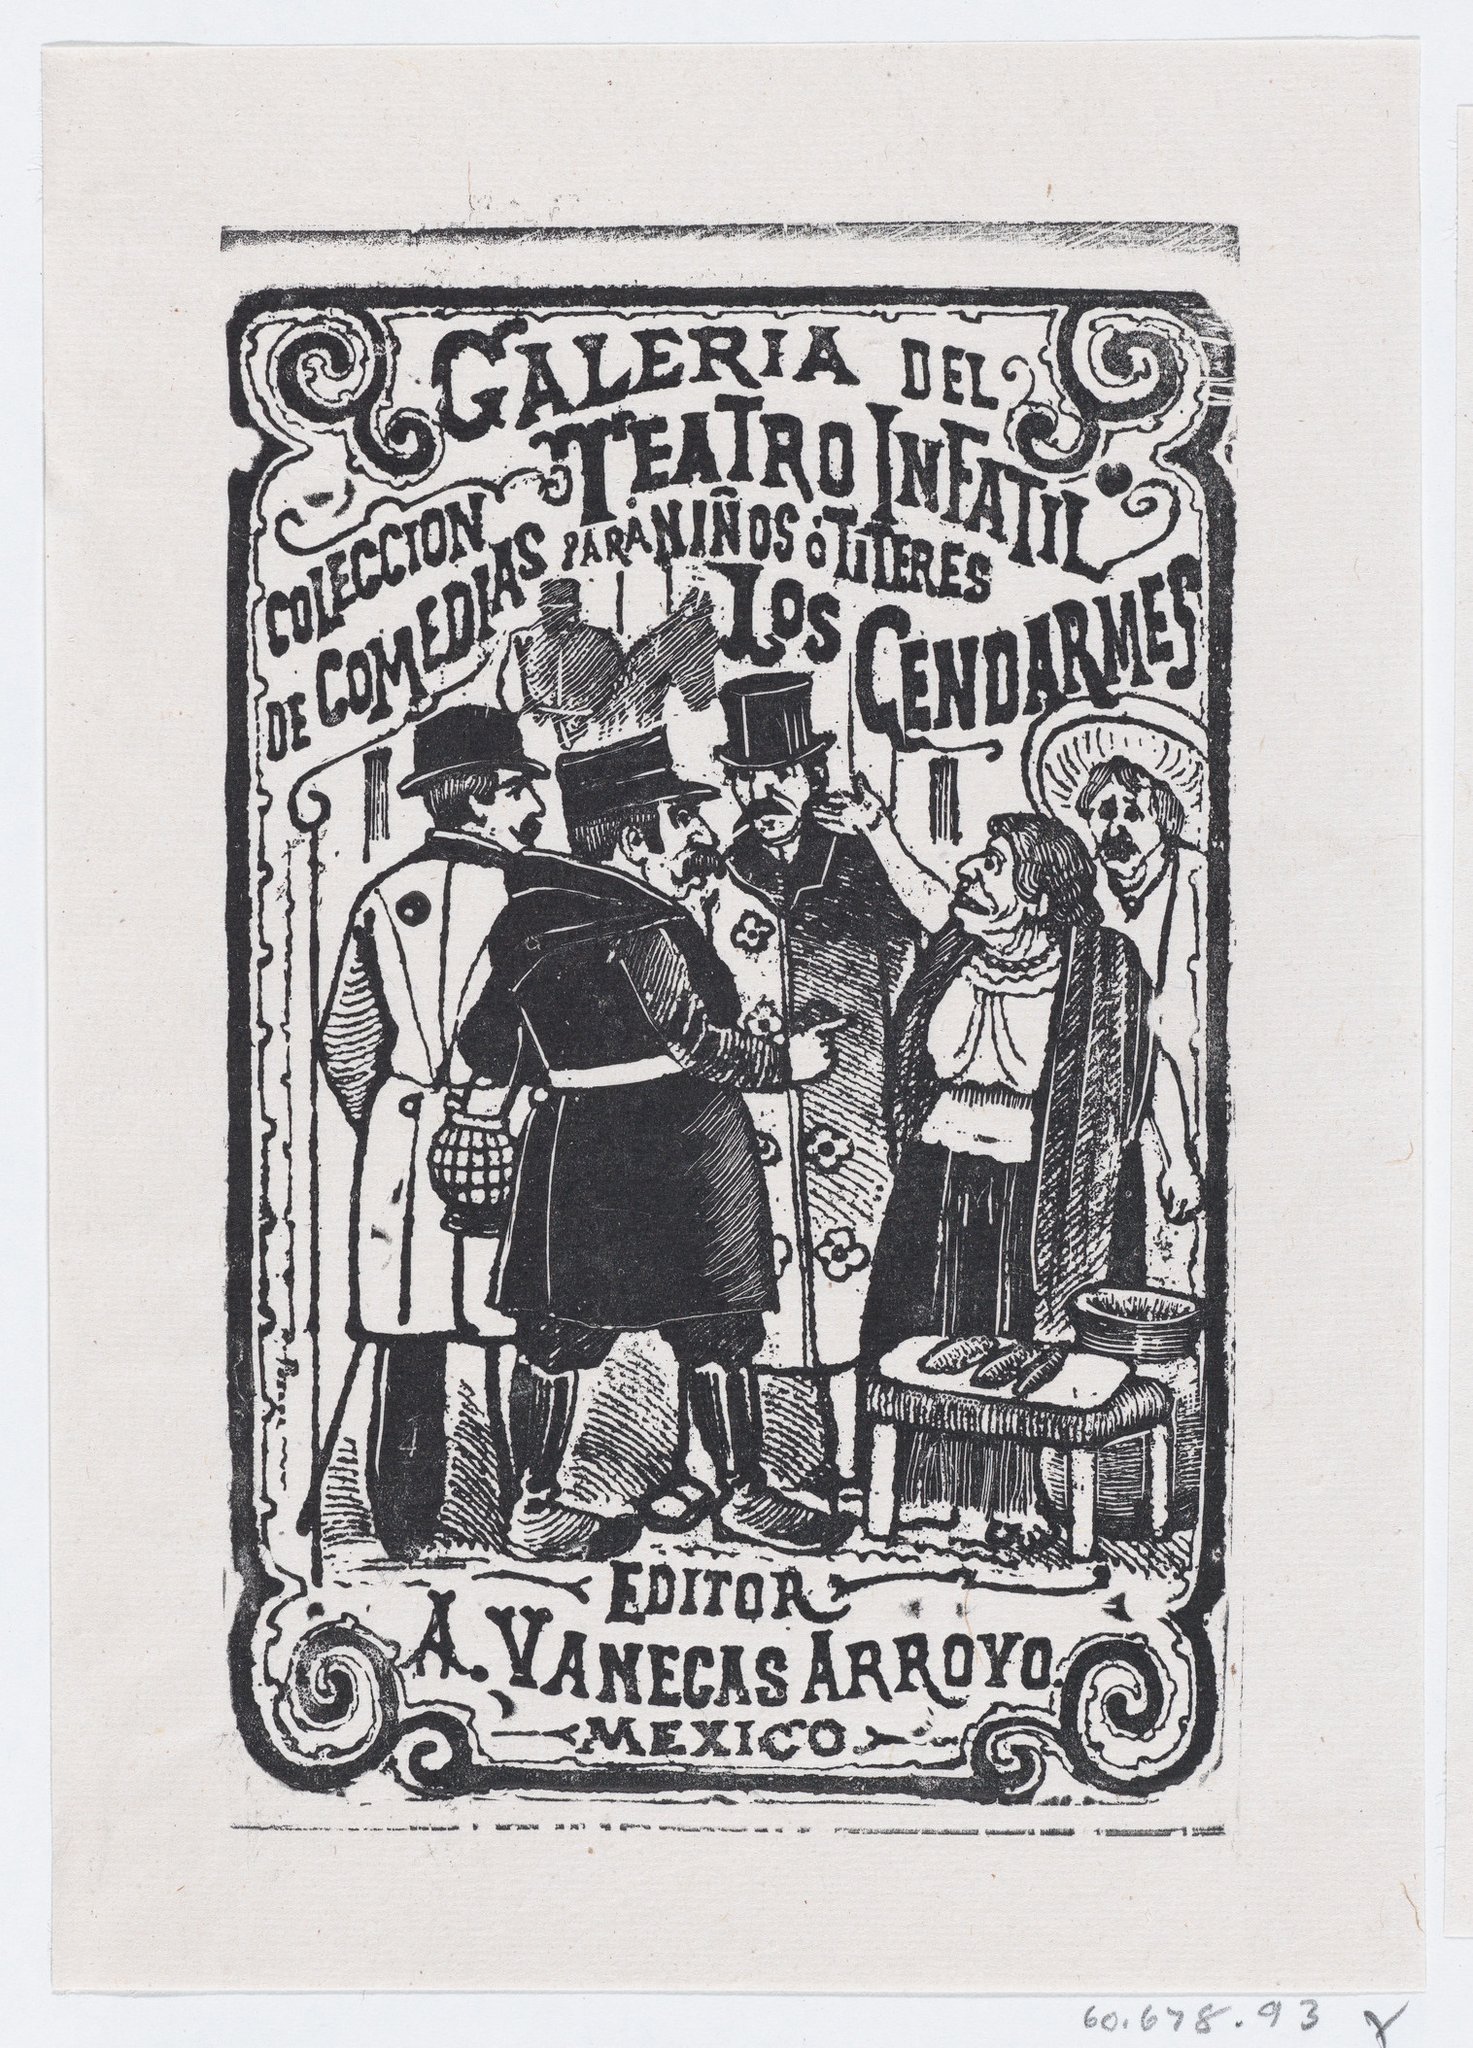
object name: print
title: An old female vendor talking to a group of gentlemen, illustration for 'Los Cendarmes,' edited by Antonio Vanegas Arroyo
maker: josé guadalupe posada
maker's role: artist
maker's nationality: mexican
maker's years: 1852-1913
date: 1880-1910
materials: metal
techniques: engraving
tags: men,women